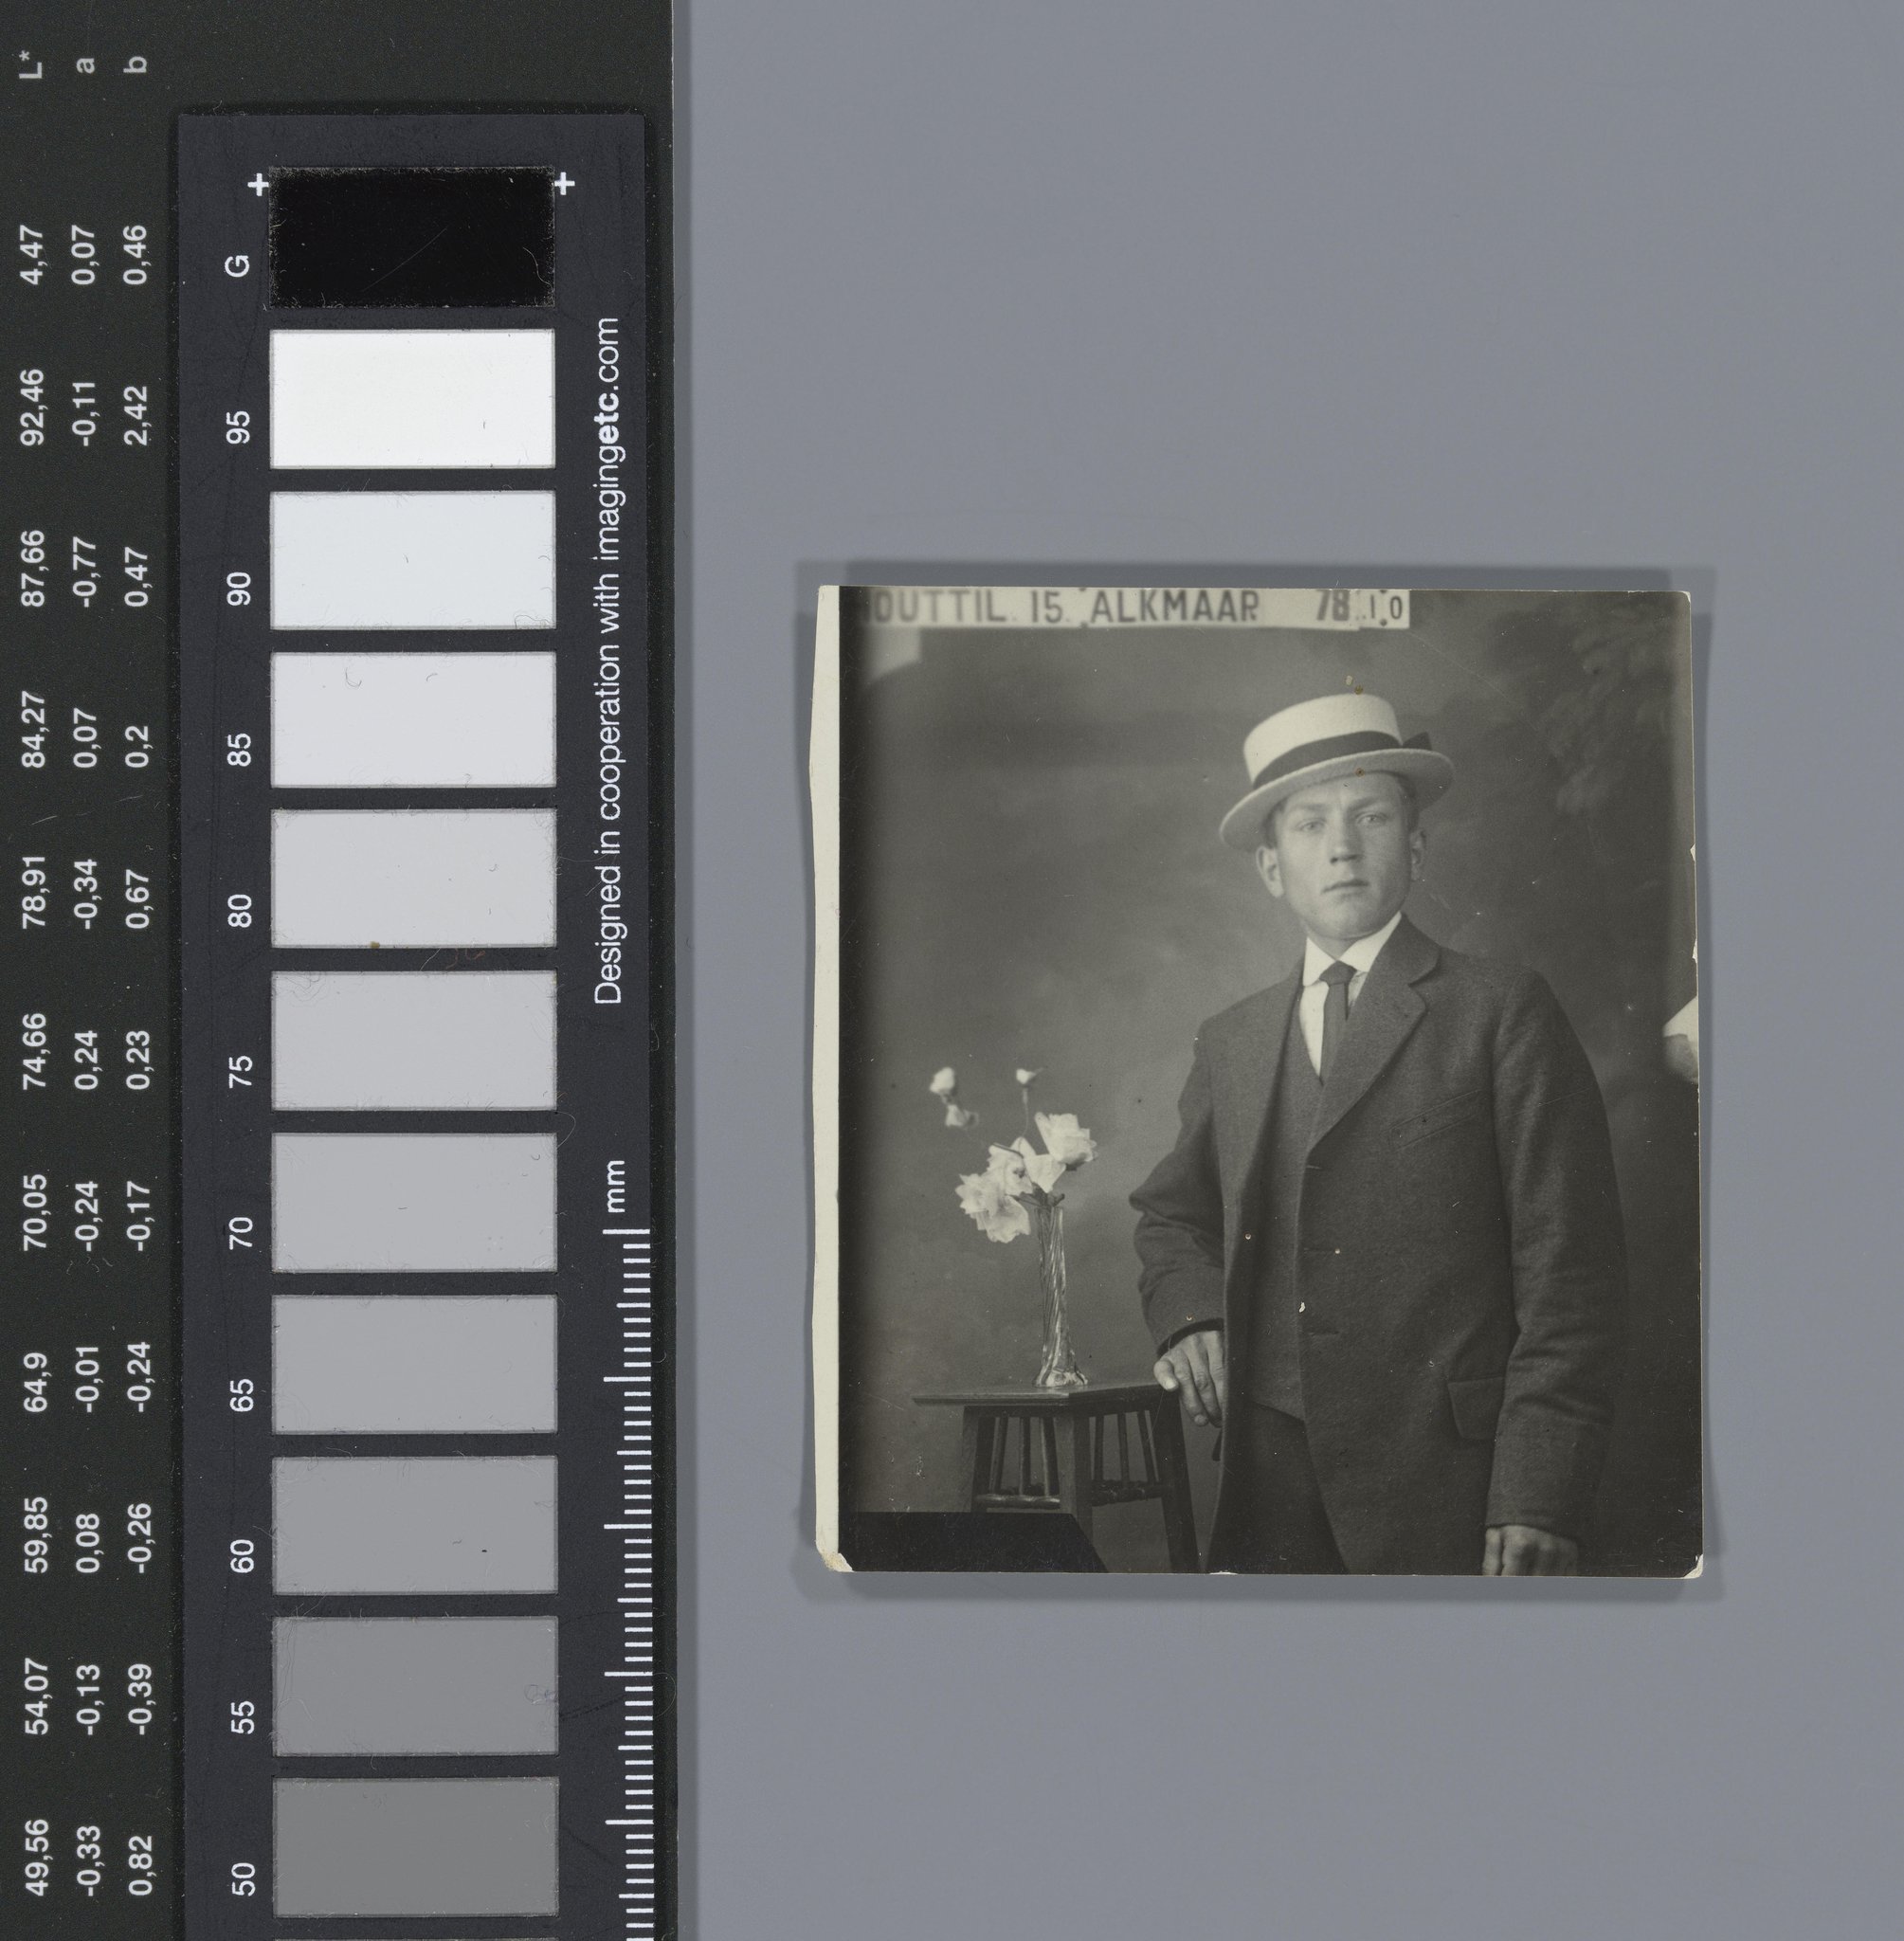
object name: snapshot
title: Rapid photographs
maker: jan gottfried stütner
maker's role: fotograaf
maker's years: 1892-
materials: photographic support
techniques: gelatin silver print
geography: alkmaar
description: Between 1912 and 1930, anyone could have their portrait taken at the many so-called rapid photography studios in the shopping streets of mainly (medium) large-size European cities. As if on an assembly line, the youngest clerk shot the photographs with a special camera and in artificial light and developed them. Later in the day, the customer collected a sheet with 12 portrait photos for 25 cents. This form of photographic mass production gave rise to a fascinating tableau of boys, girls, men and women not previously seen in photographs; candid and informal. There were at least 150 quick-photo studios, from Alkmaar to Zutphen. Many called themselves ‘American,’ mistakenly as it turns out because hardly any examples from that country have been found.